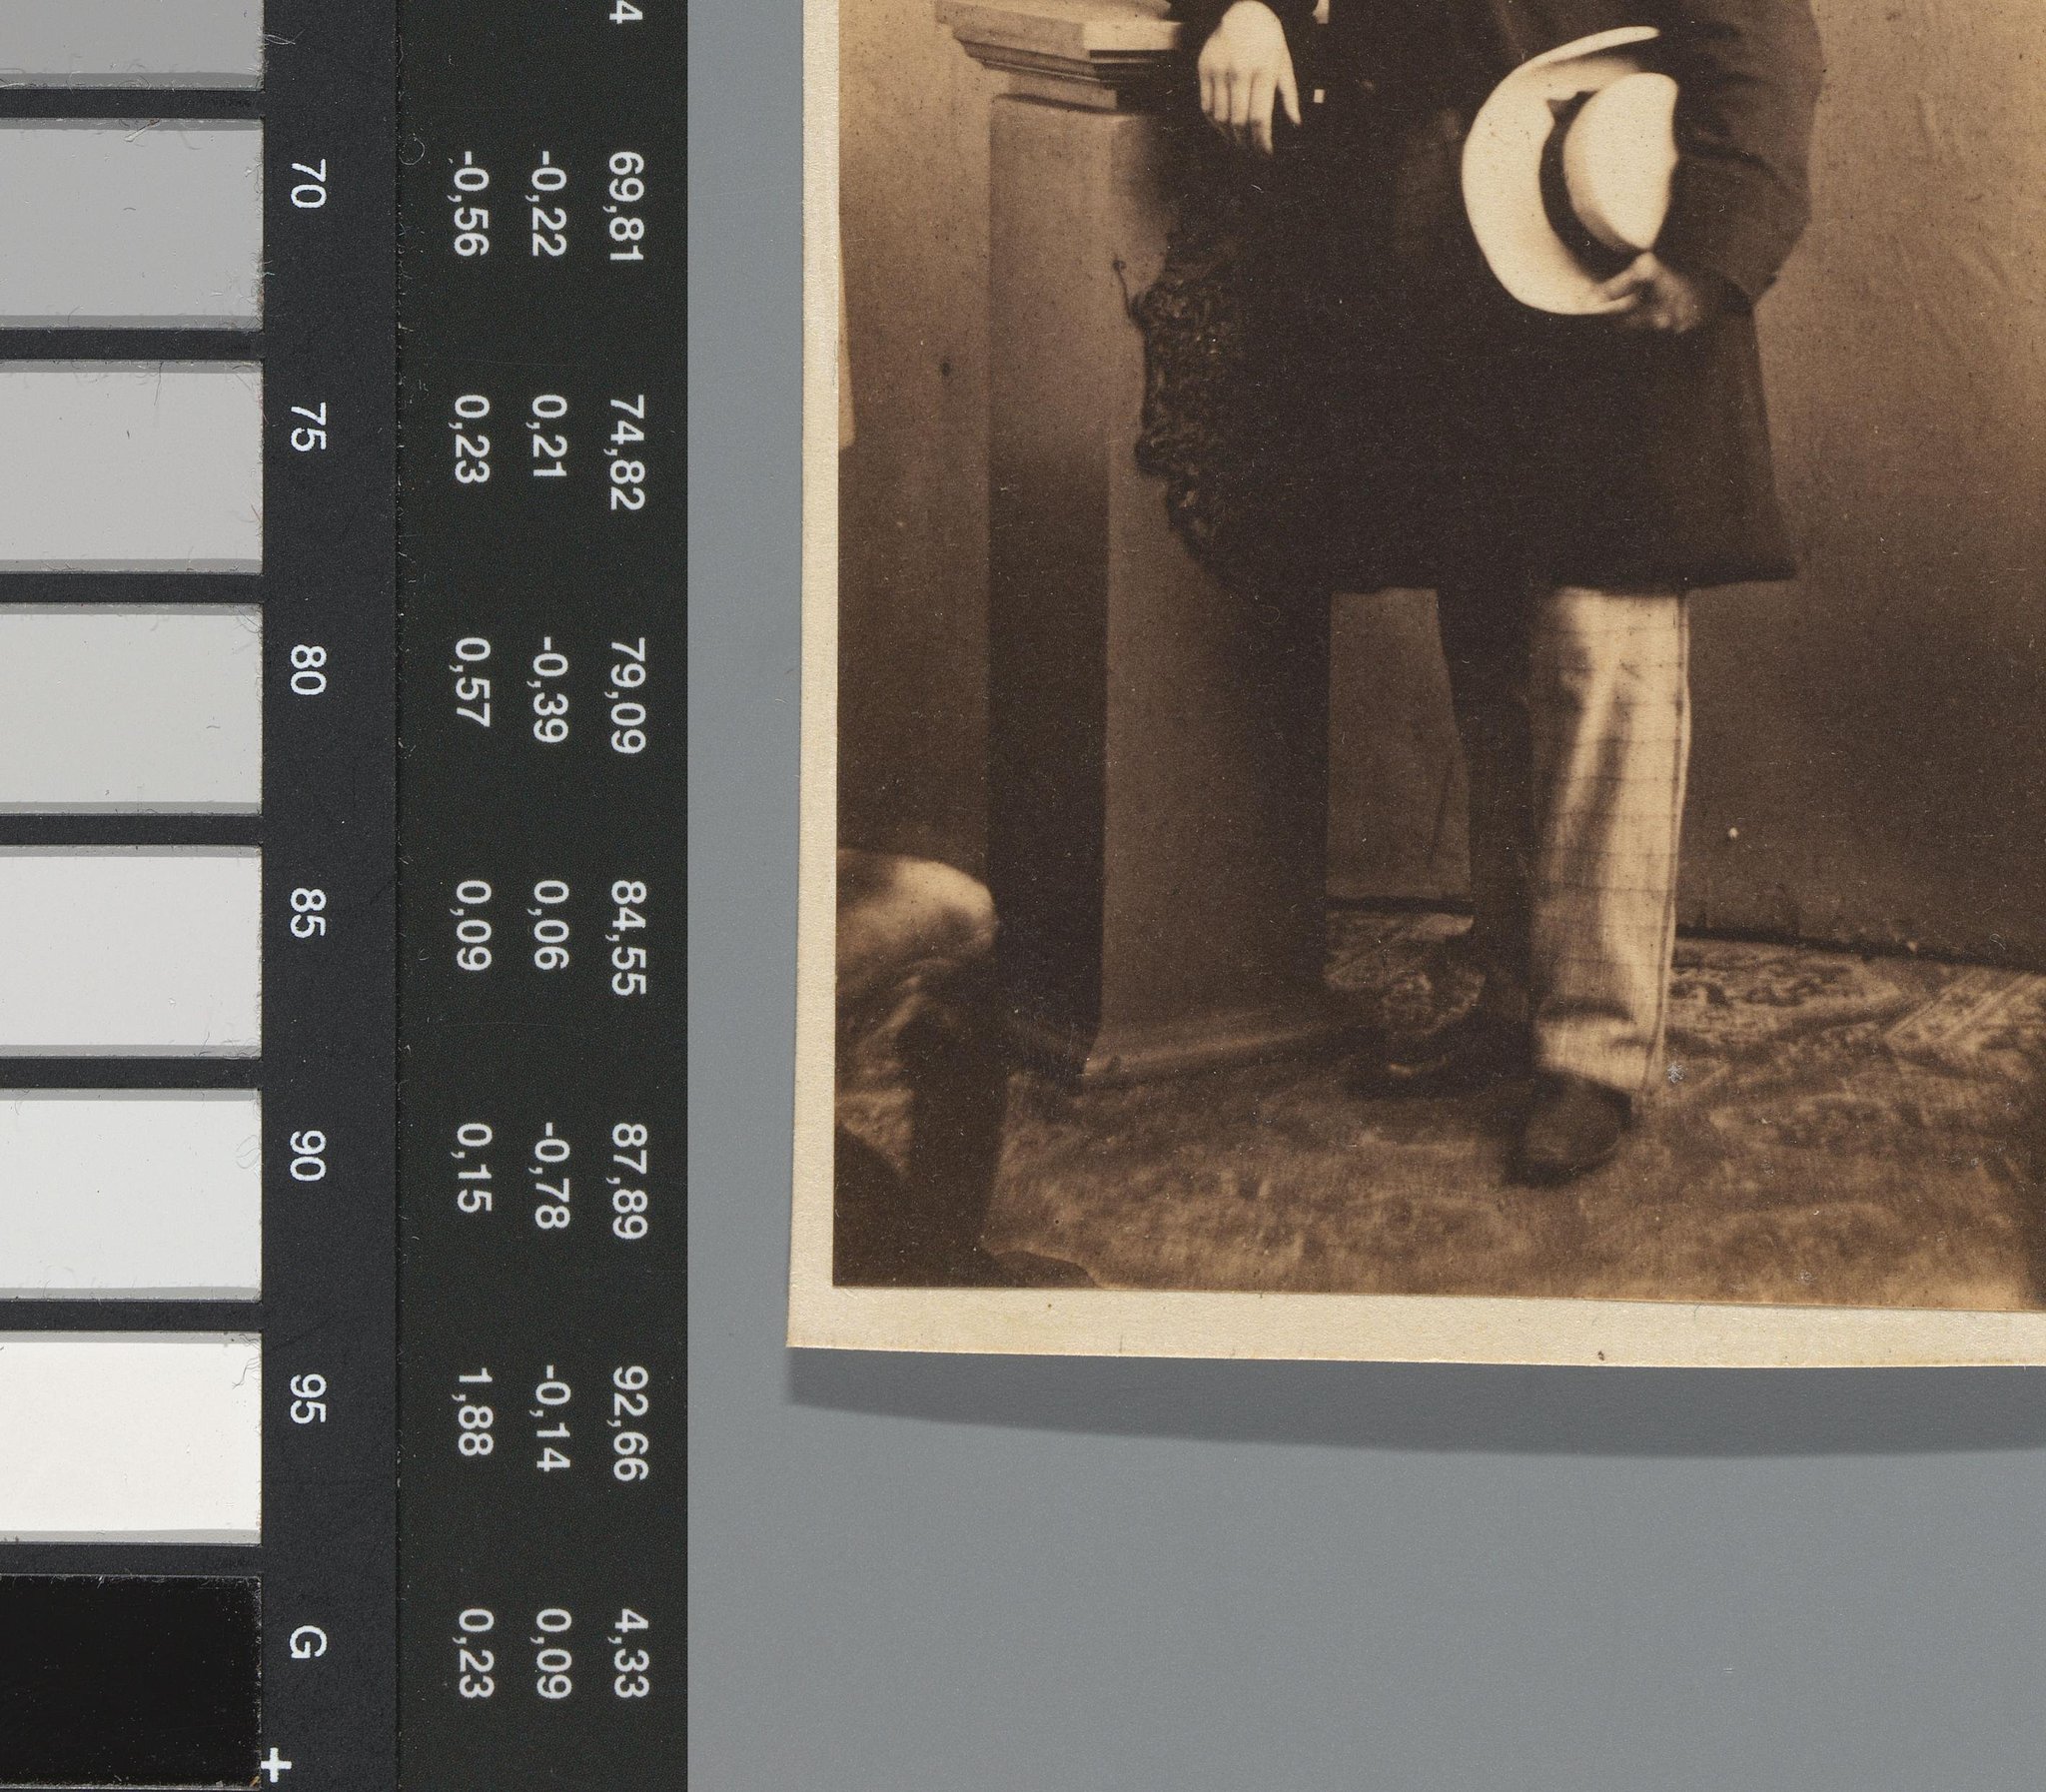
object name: photograph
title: Portret van Petrus Johannes van den Berg (Piet)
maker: a. böeseken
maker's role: fotograaf, lithograaf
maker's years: 1834-1919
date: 1855-1910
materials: cardboard, photographic support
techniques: albumen print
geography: rotterdam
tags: notaris, petrus johannes van den berg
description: Staande man met hoed in de hand leunend op een sokkel.